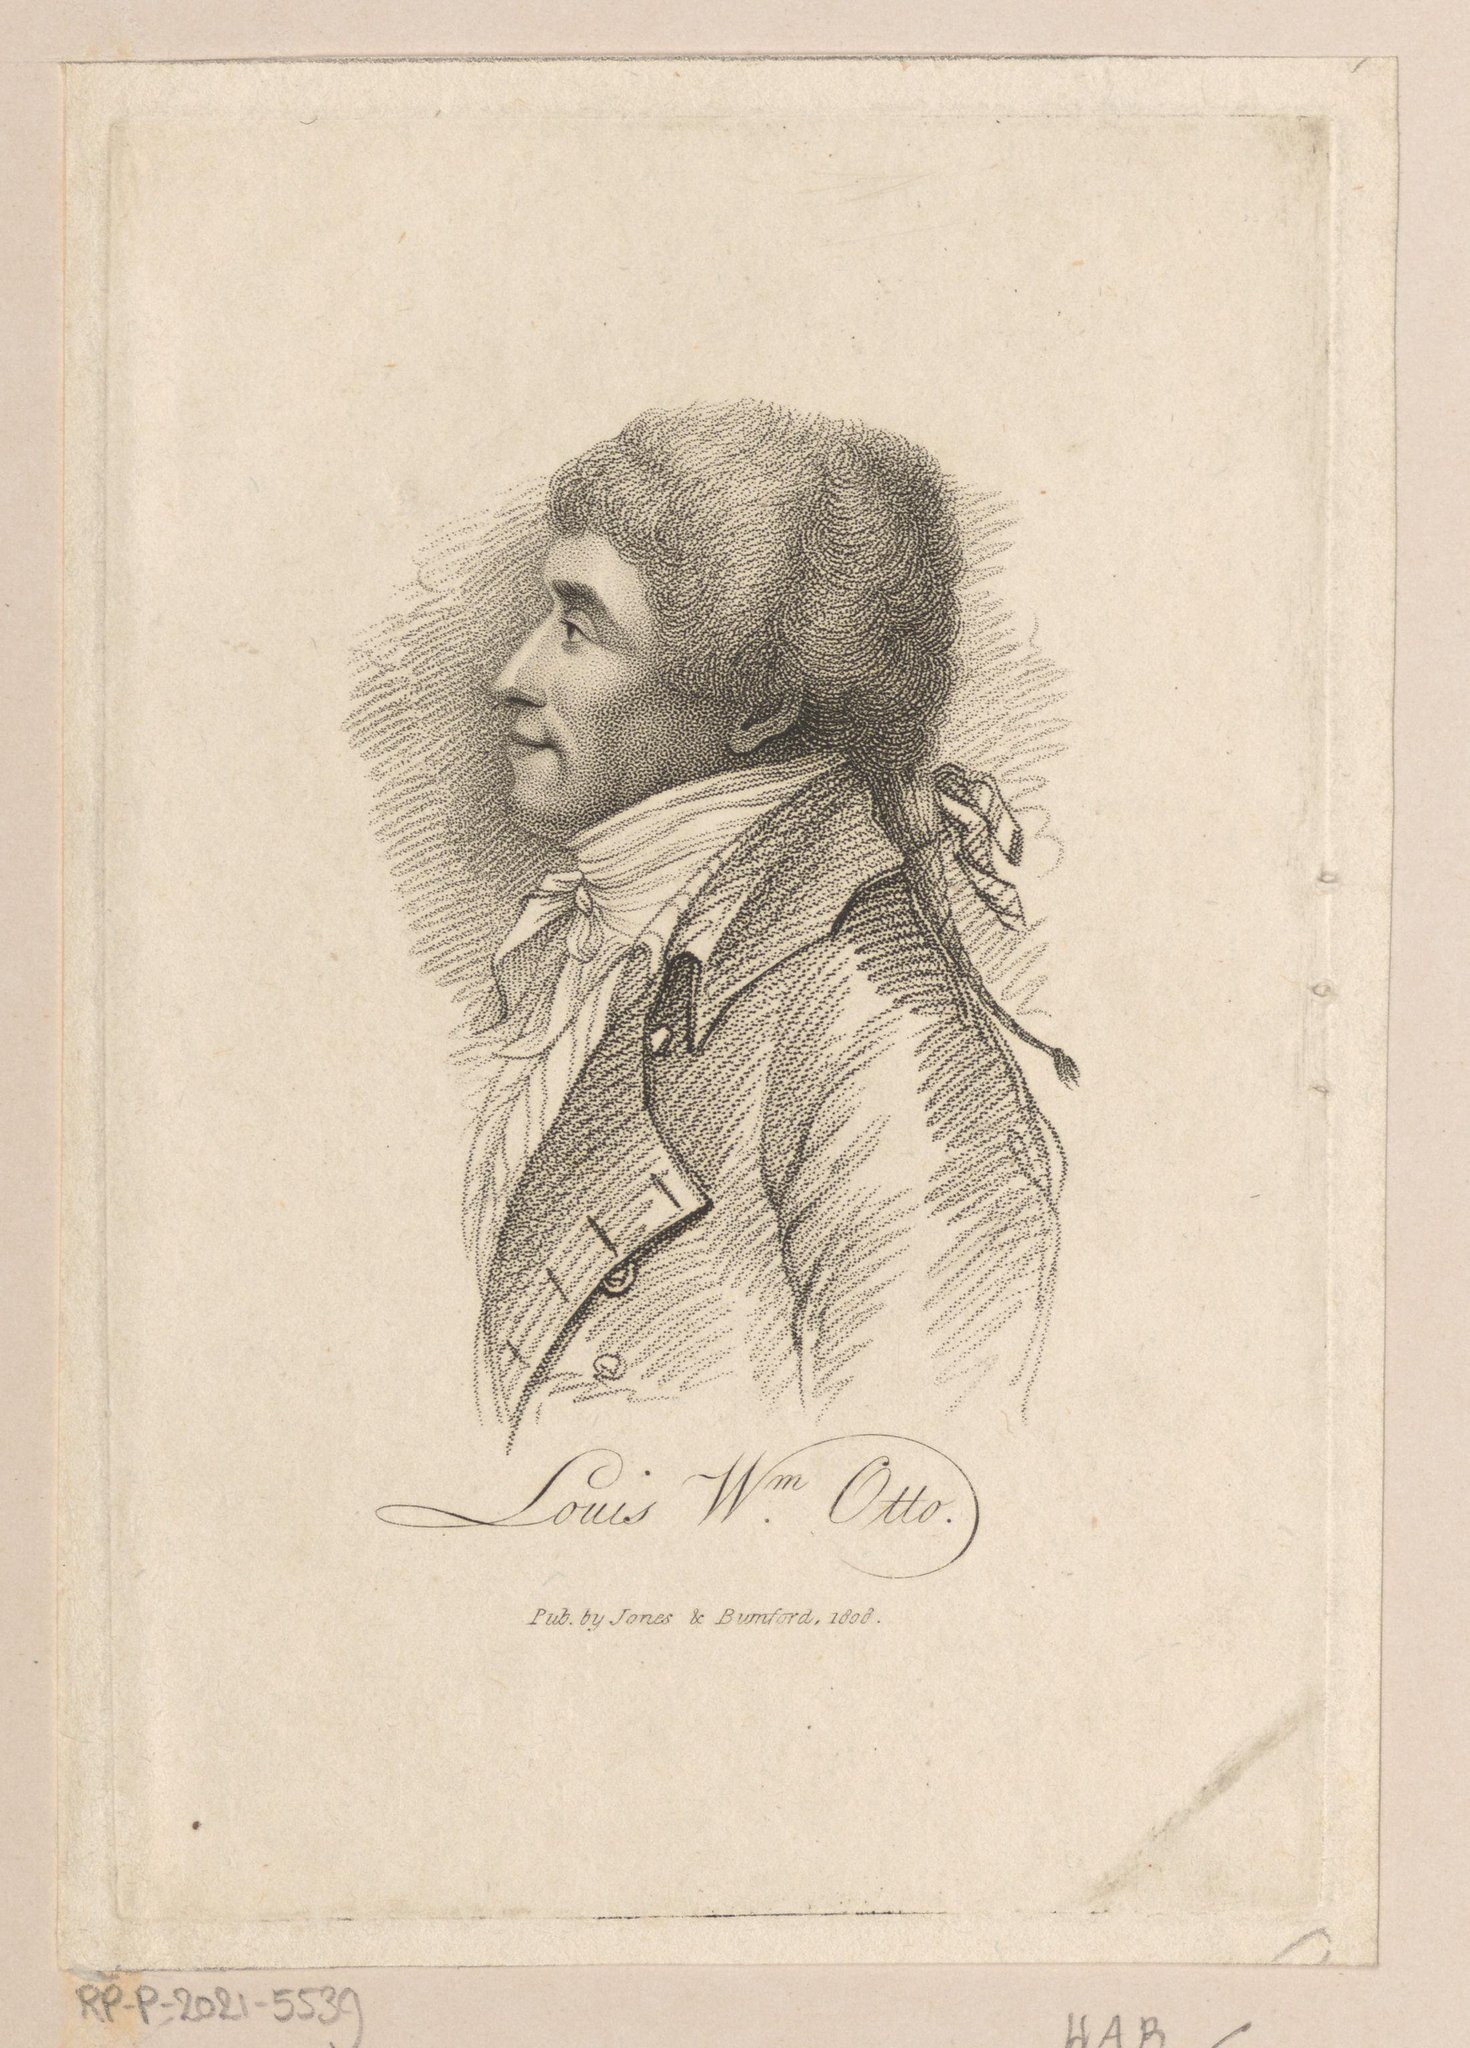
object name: print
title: Portret van Louis-Guillaume Otto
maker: Anonymous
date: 1808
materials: paper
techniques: engraving, roulette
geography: london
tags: paris, historical persons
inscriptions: date